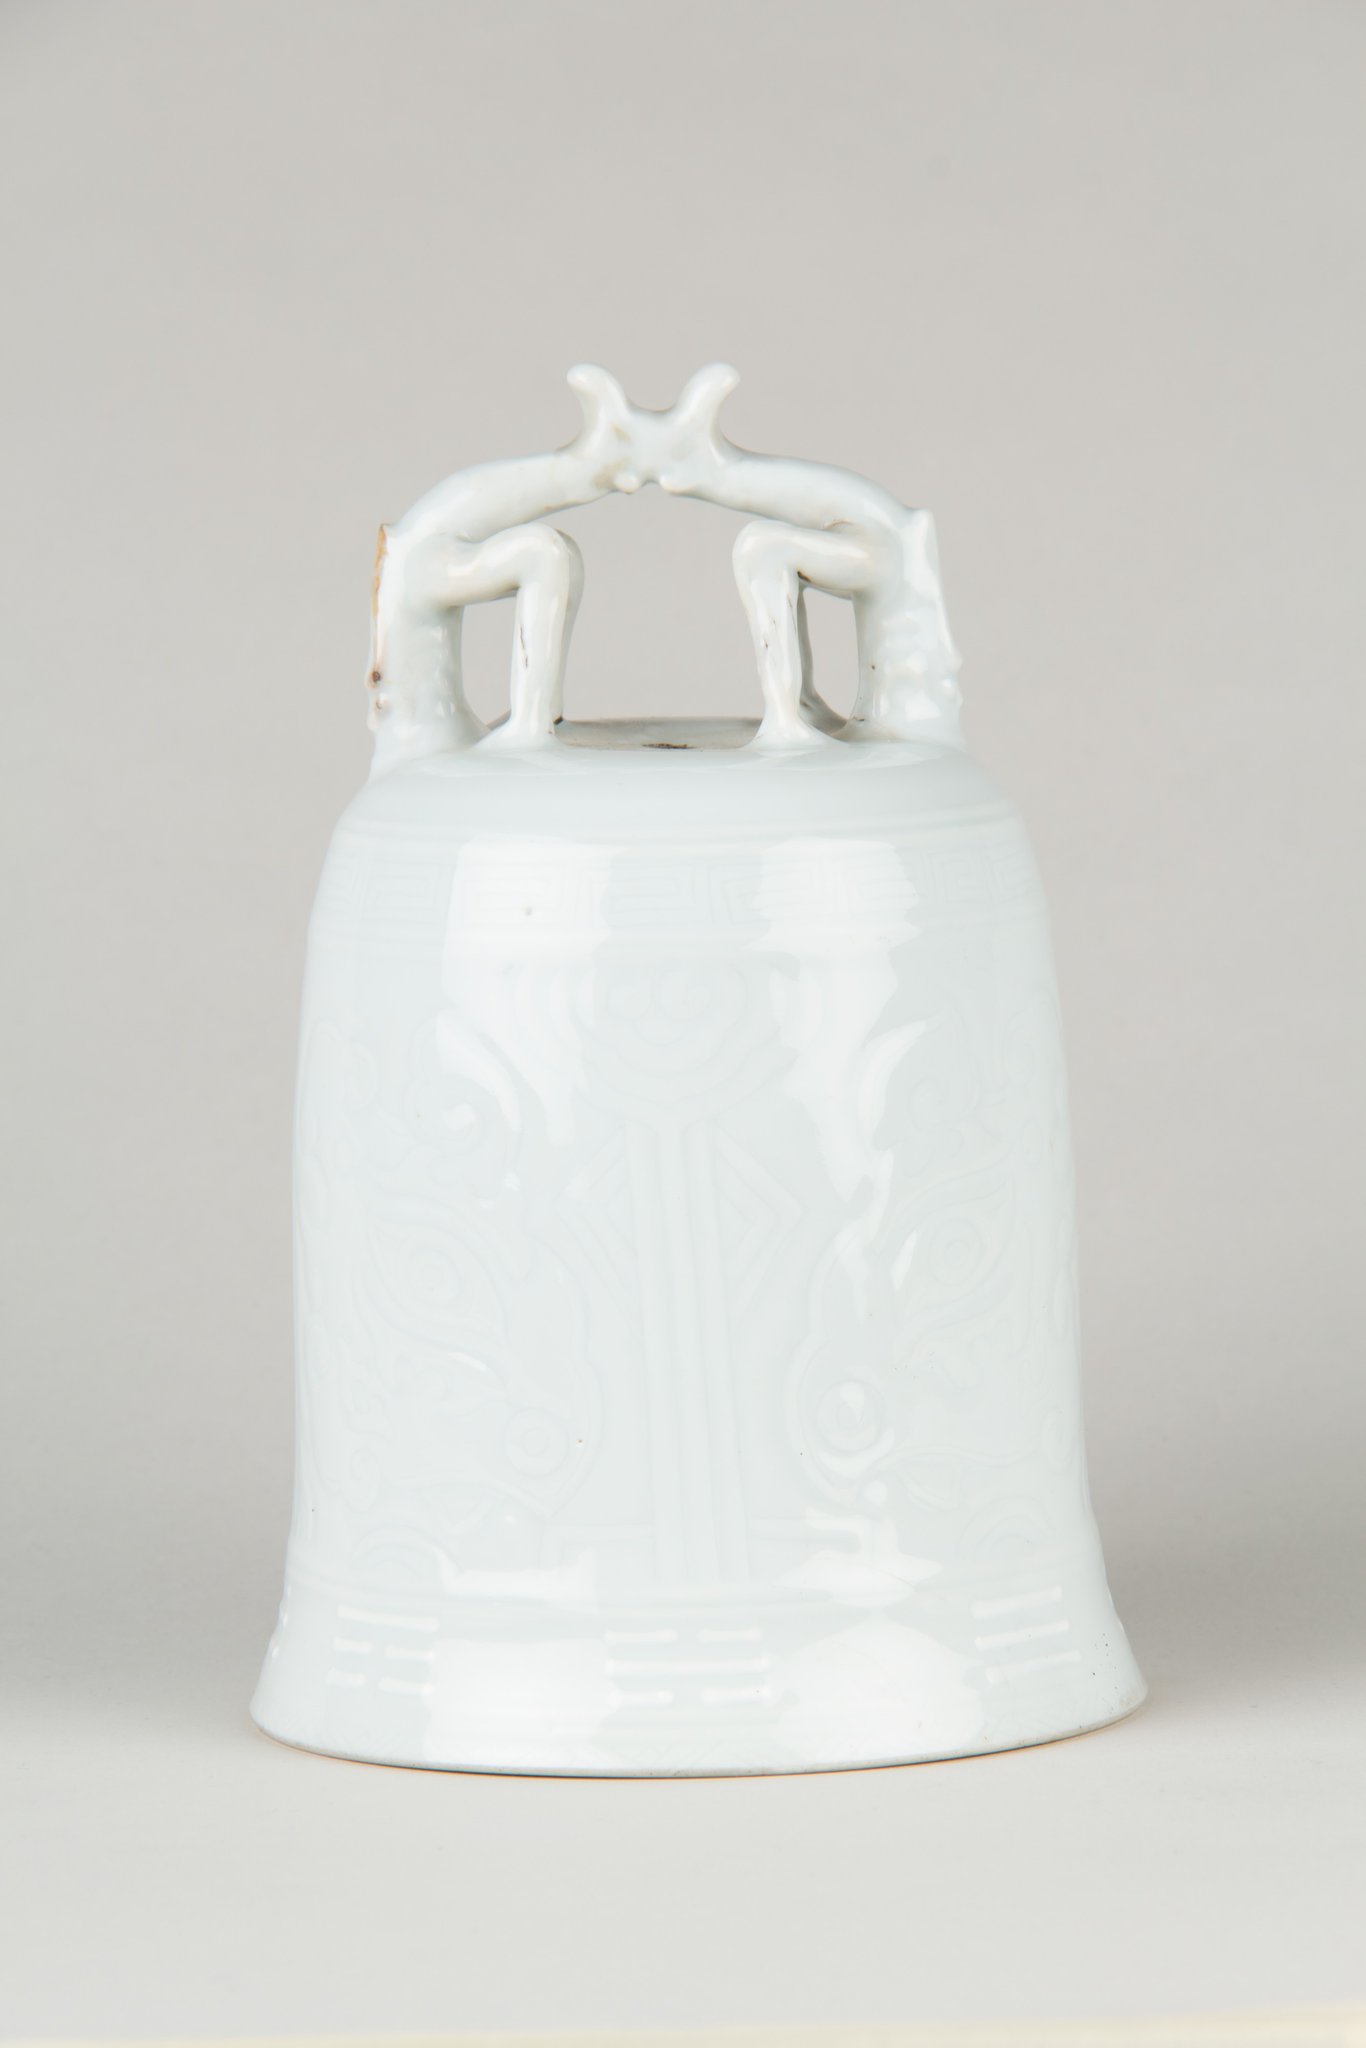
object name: bell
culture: chinese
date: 1701-1800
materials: glaze, porcelain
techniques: relief